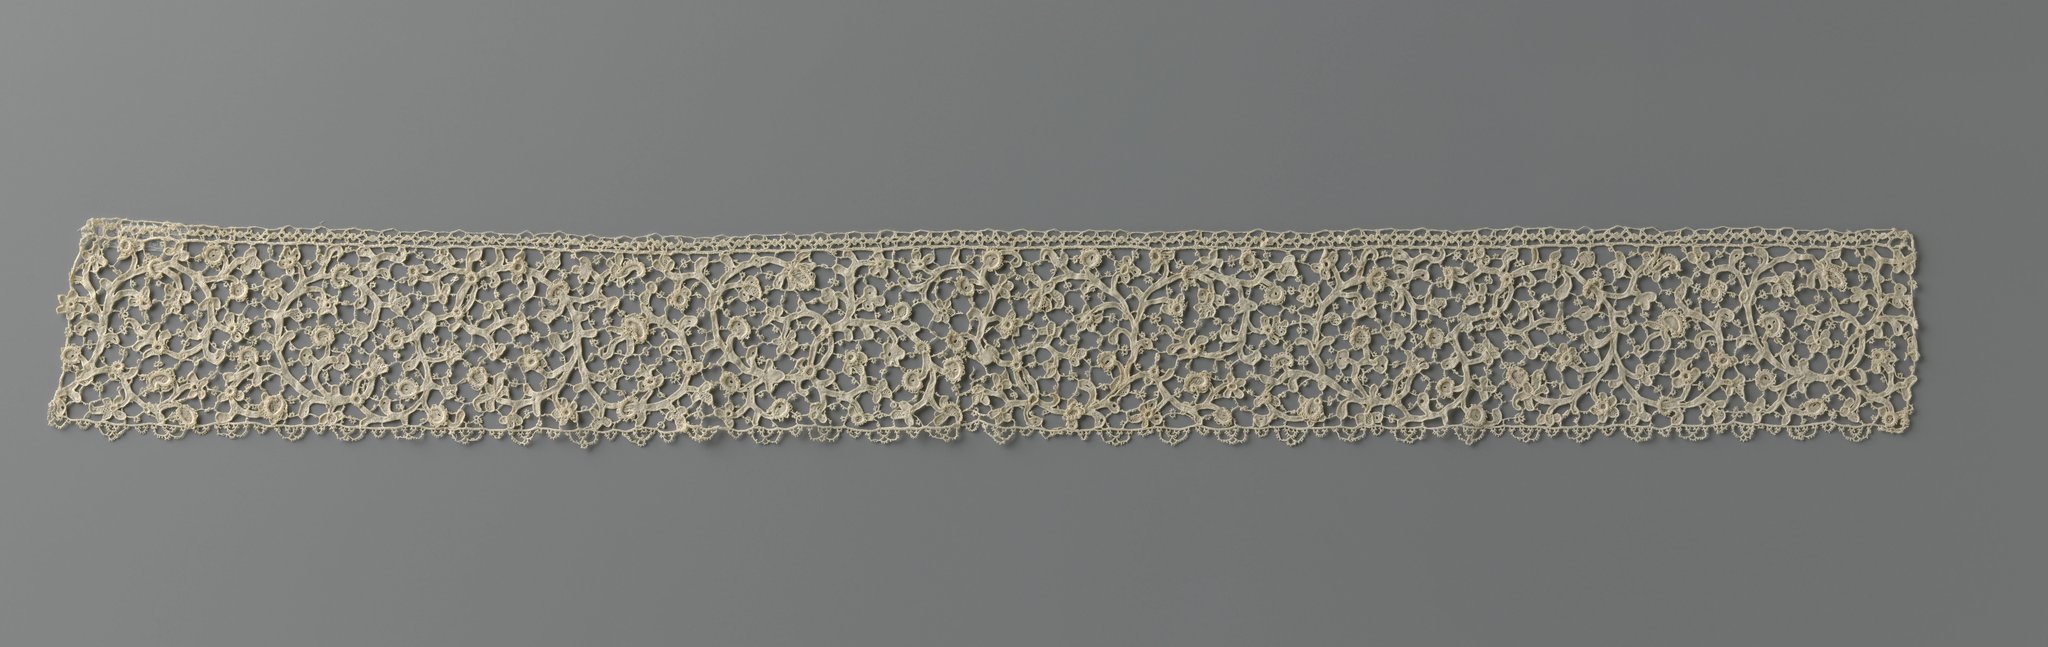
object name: strip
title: Strook of kraag van naaldkant met fijne ranken en bloempjes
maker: Anonymous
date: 1685-1699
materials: linen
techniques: rose point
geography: venice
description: Strook of kraag van naturelkleurige naaldkant: Venetiaanse rozenkant. Het patroon bestaat uit fijne omkrullend en zich splitsende ranken met daaraan vele kleine blaadjes en veelsoortige bloempjes. De motieven zijn gemaakt met festonsteken. Door draaiïngen in de festonsteken toe te passen zijn fijne uitsparingen ontstaan die patronen vormen in verschillende bloemblaadjes en bladeren. In enkele motieven zijn siersteken toegepast. Langs alle motieven lopen reliëfcontouren en rond de bloemharten zijn verdikkingen met cordons gerealiseerd, die zijn versierd met (rader)picots. De motieven zijn met elkaar verbonden door gepicoteerde spijlen. De bovenzijde van de strook is recht afgewerkt met een geklost bandje. De onderzijde is afgewerkt met een boogjesrandje. De korte zijden zijn min of meer recht afgewerkt.